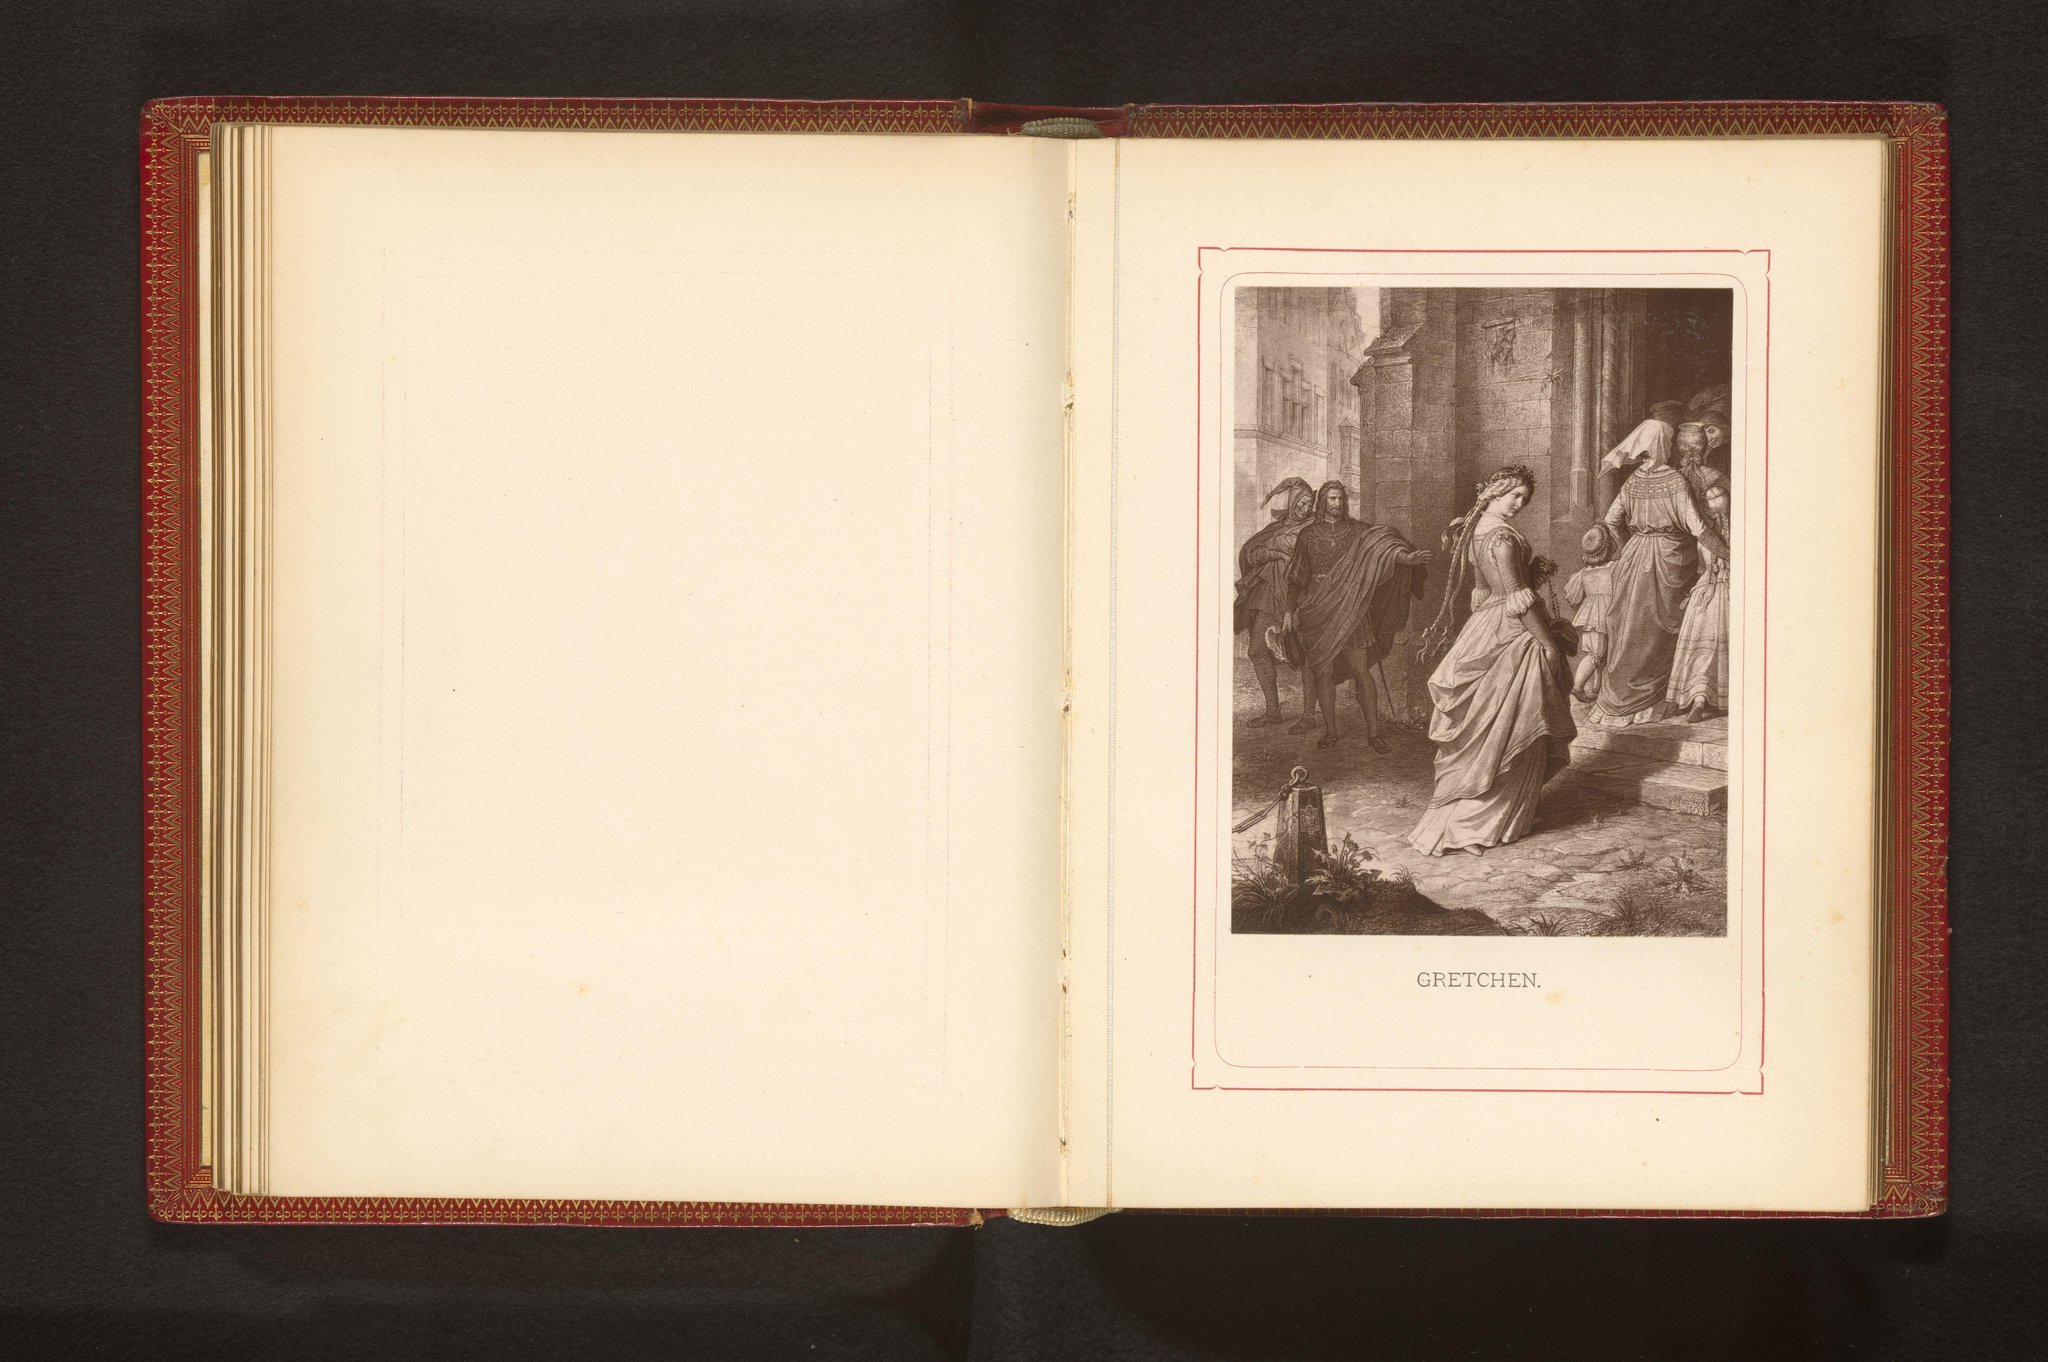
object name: reproduction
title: Gretchen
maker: Anonymous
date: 1875-1885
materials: paper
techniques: photograph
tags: adult woman, going to church, (scenes from) specific works of literature: goethe, faust